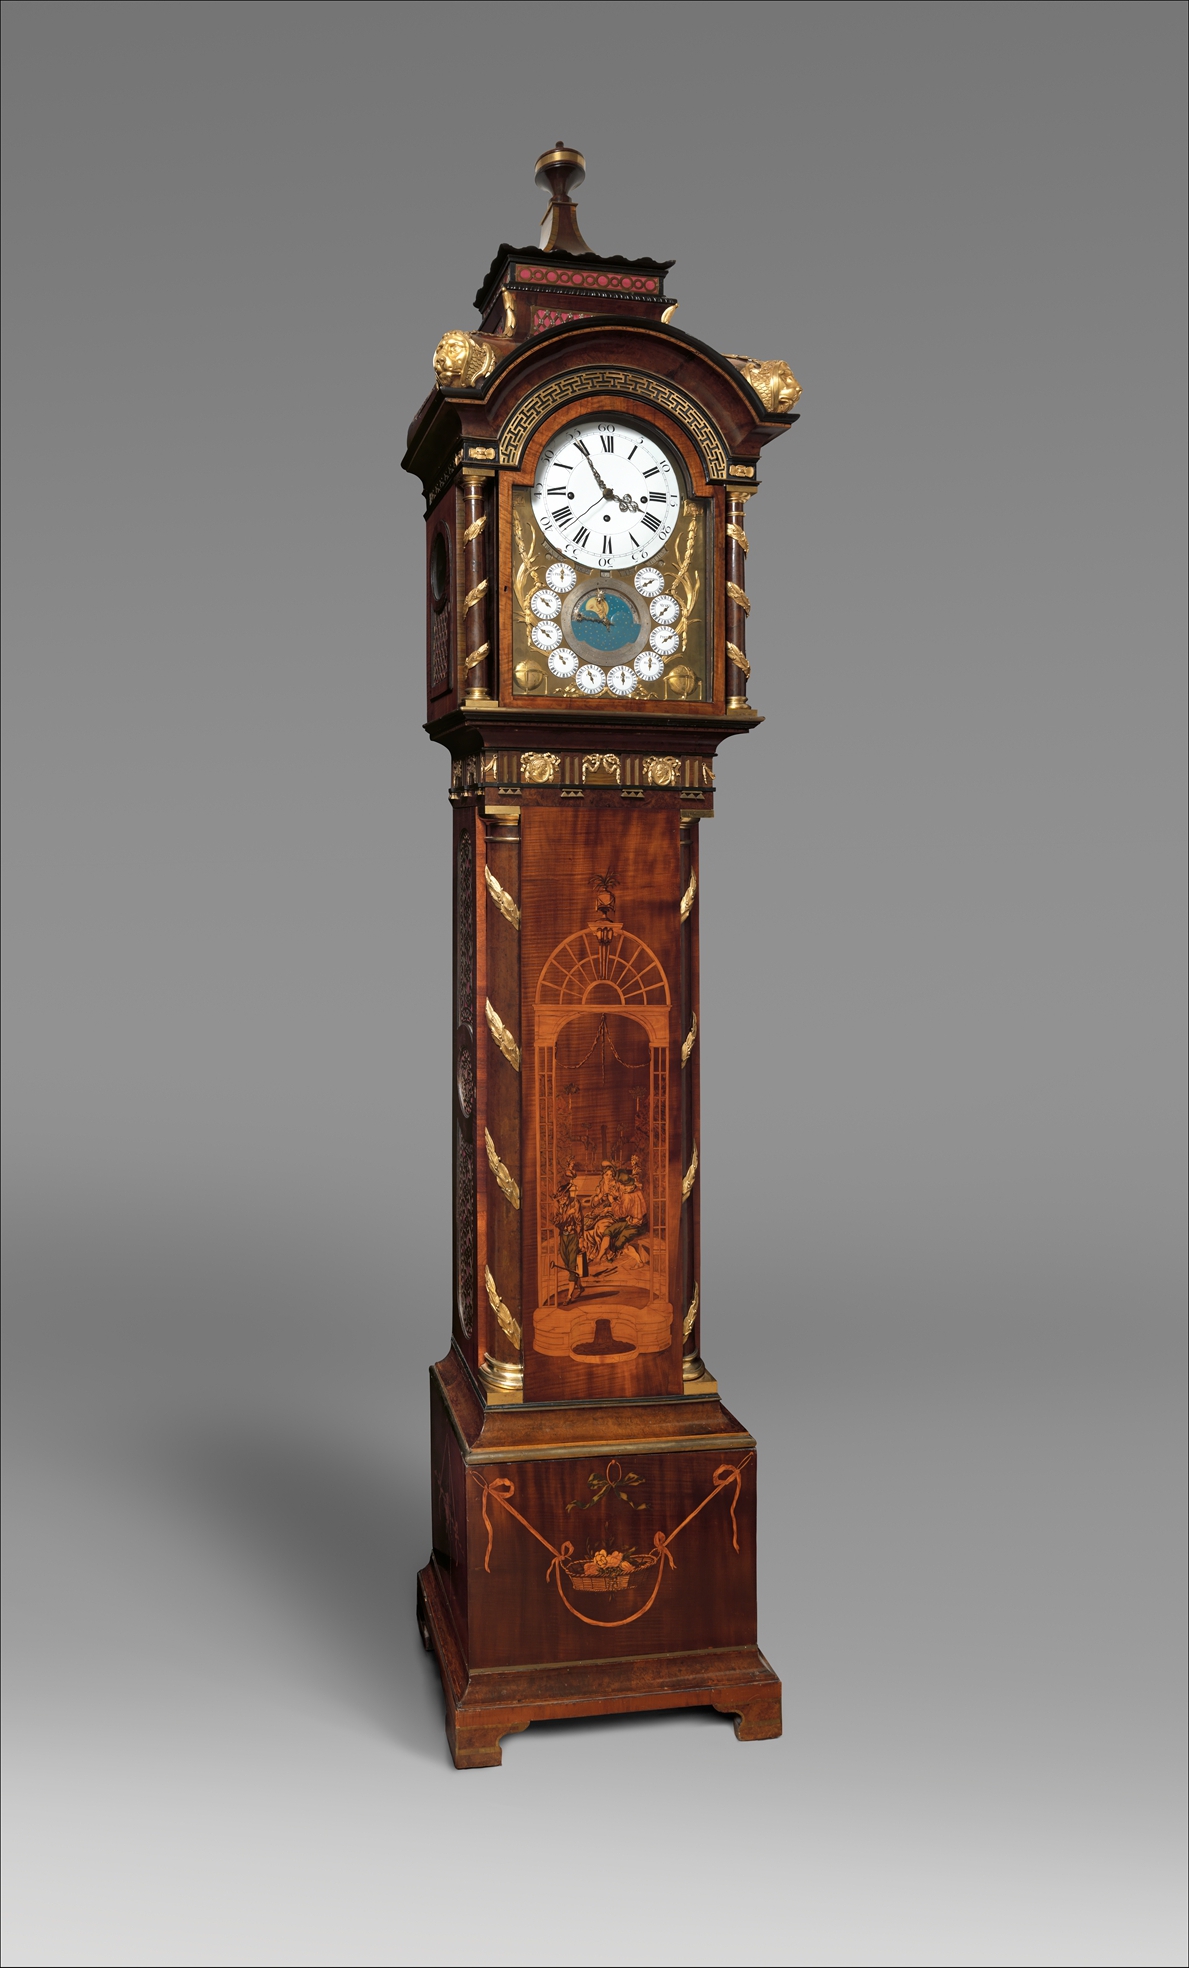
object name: longcase clock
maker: hermann achenbach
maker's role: maker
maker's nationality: german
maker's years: 1725-1825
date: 1774-1775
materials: brass, bronze, copper, wood, mother of pearl, steel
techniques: enamel, gilding, painting, silvered, stain, veneering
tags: astronomy,zodiac